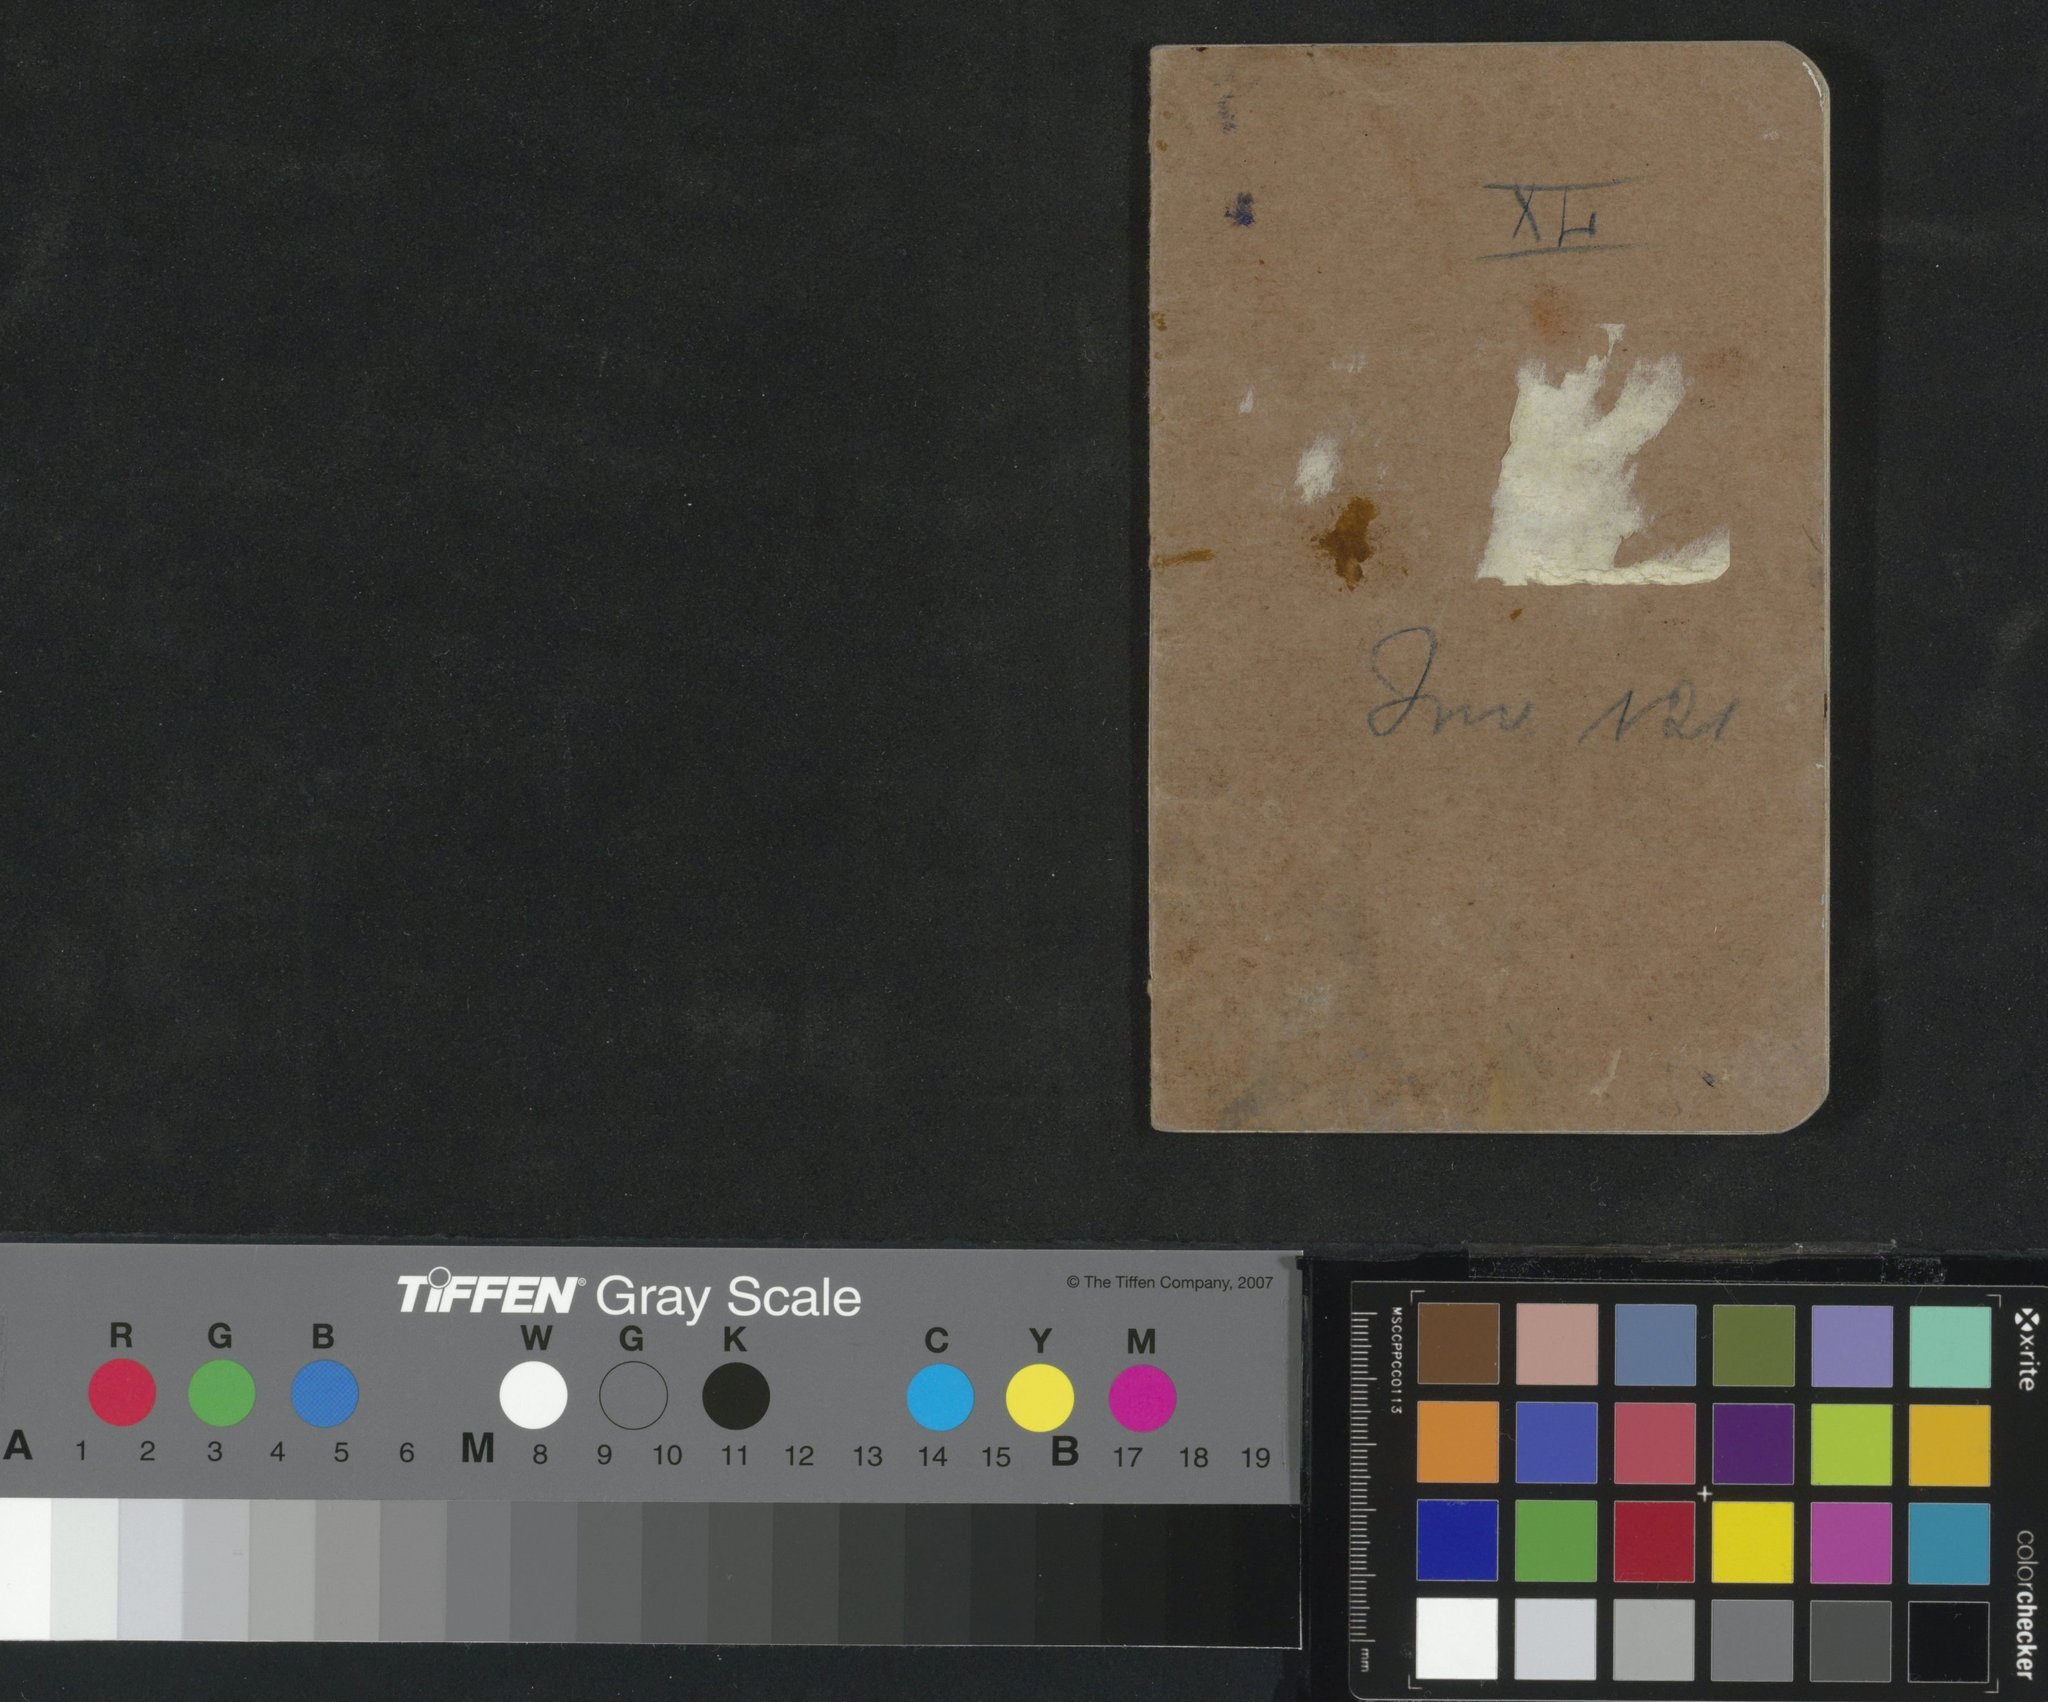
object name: sketchbook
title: Schetsboek XL met 40 pagina's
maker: isaac israels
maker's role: draughtsman, painter, print maker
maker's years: 1865-1934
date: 1875-1934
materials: pencil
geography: the hague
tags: adult woman, in or beside the water (on the beach)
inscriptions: collector's mark: Lugt 2228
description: Pagina's 6, 8, 19, 30 t/m 33, 35, 37 en 39 zijn blanco en daarom niet beschreven.